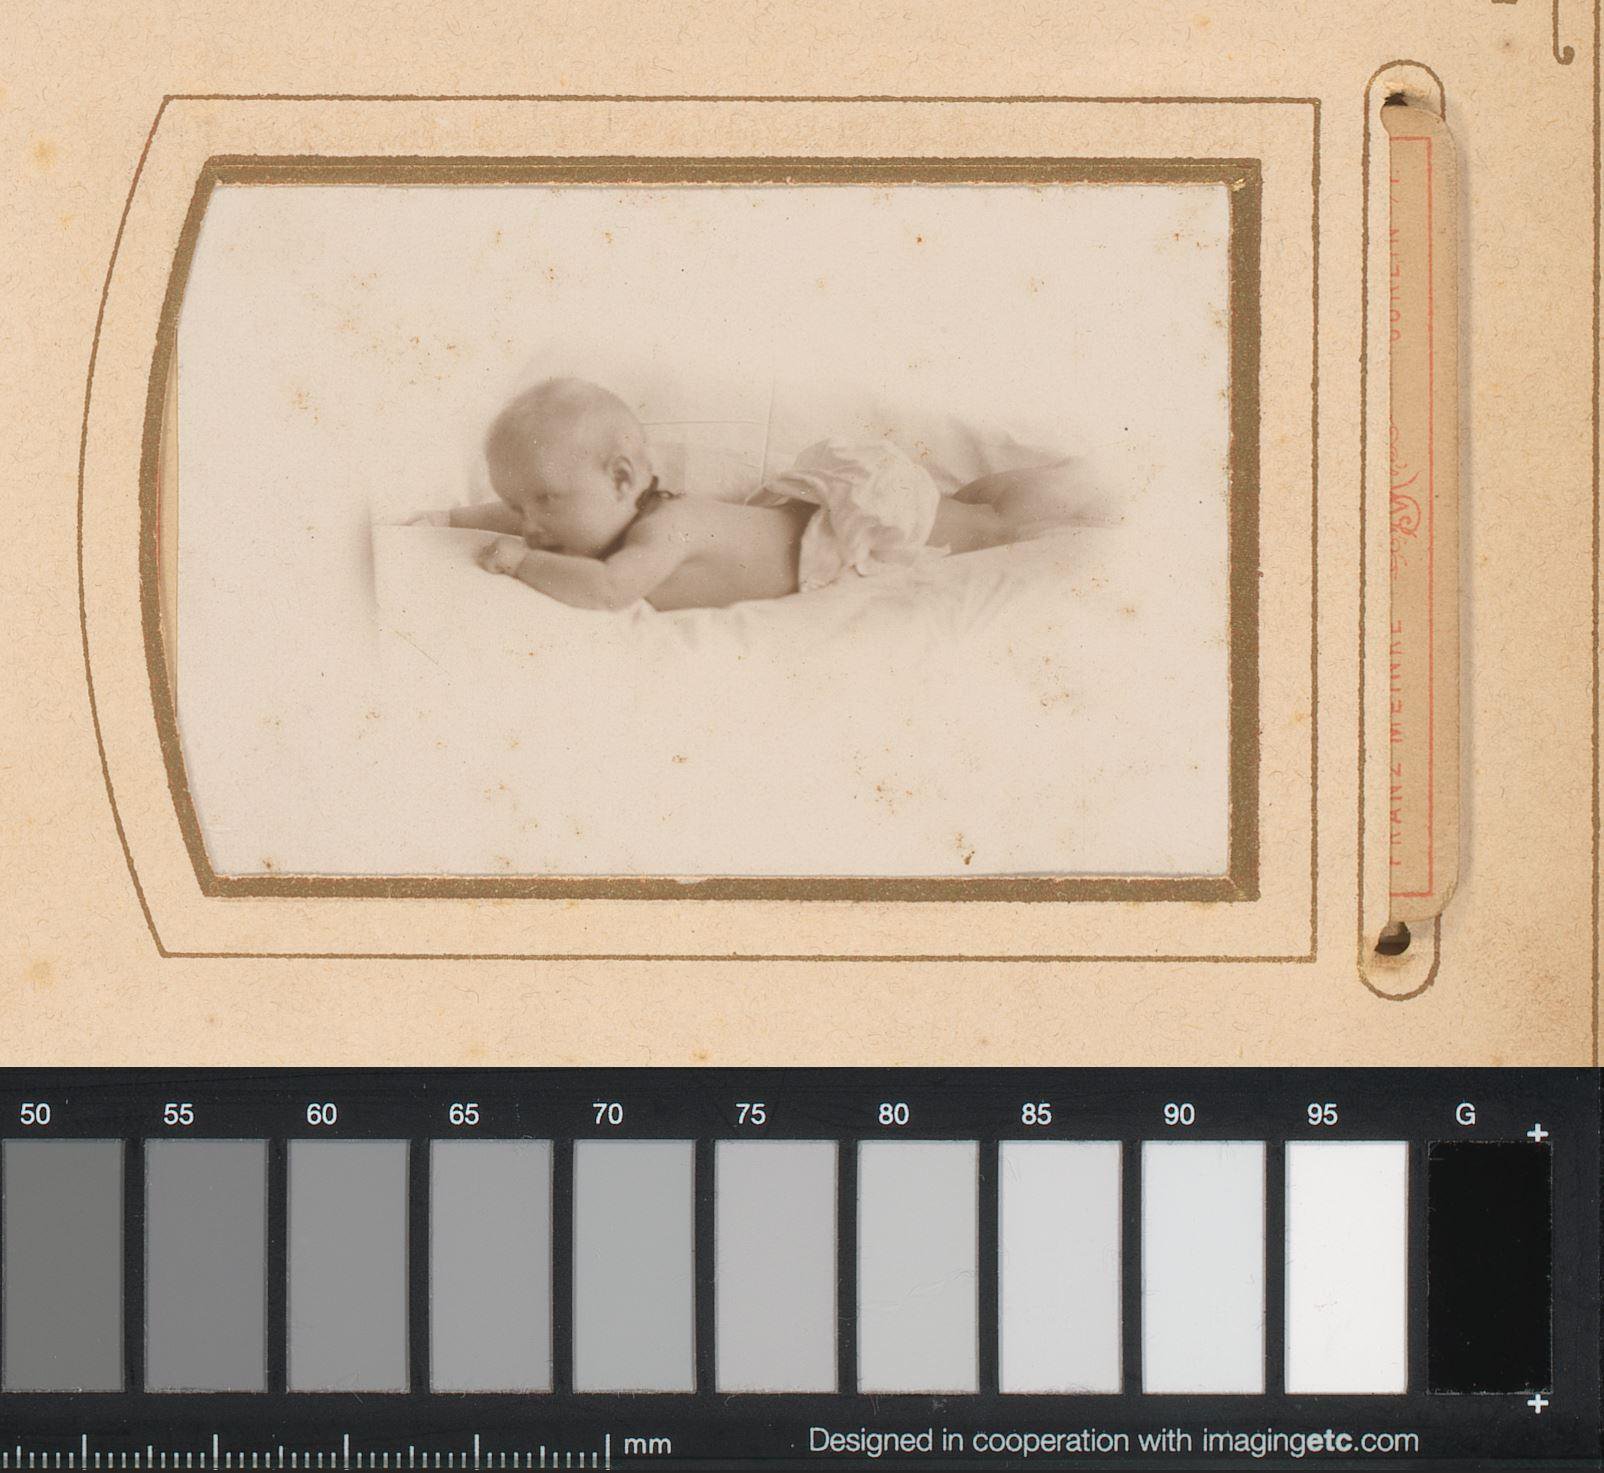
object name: photograph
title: Portret van een baby, aangeduid als Werner von Holtzendorff Falkenburg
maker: franz meinke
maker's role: fotograaf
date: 1894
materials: cardboard, photographic support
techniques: collodion silver print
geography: karlino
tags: confinement, birth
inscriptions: inscription: ‘Photographisch-artistsich-mechanisches Atelier/ Franz Meinke/ Cörlin a/ Persante’, annotation: ‘Jung Werner von Holtzendorff Falkenburg im Mei 1894 [...] Nelly’